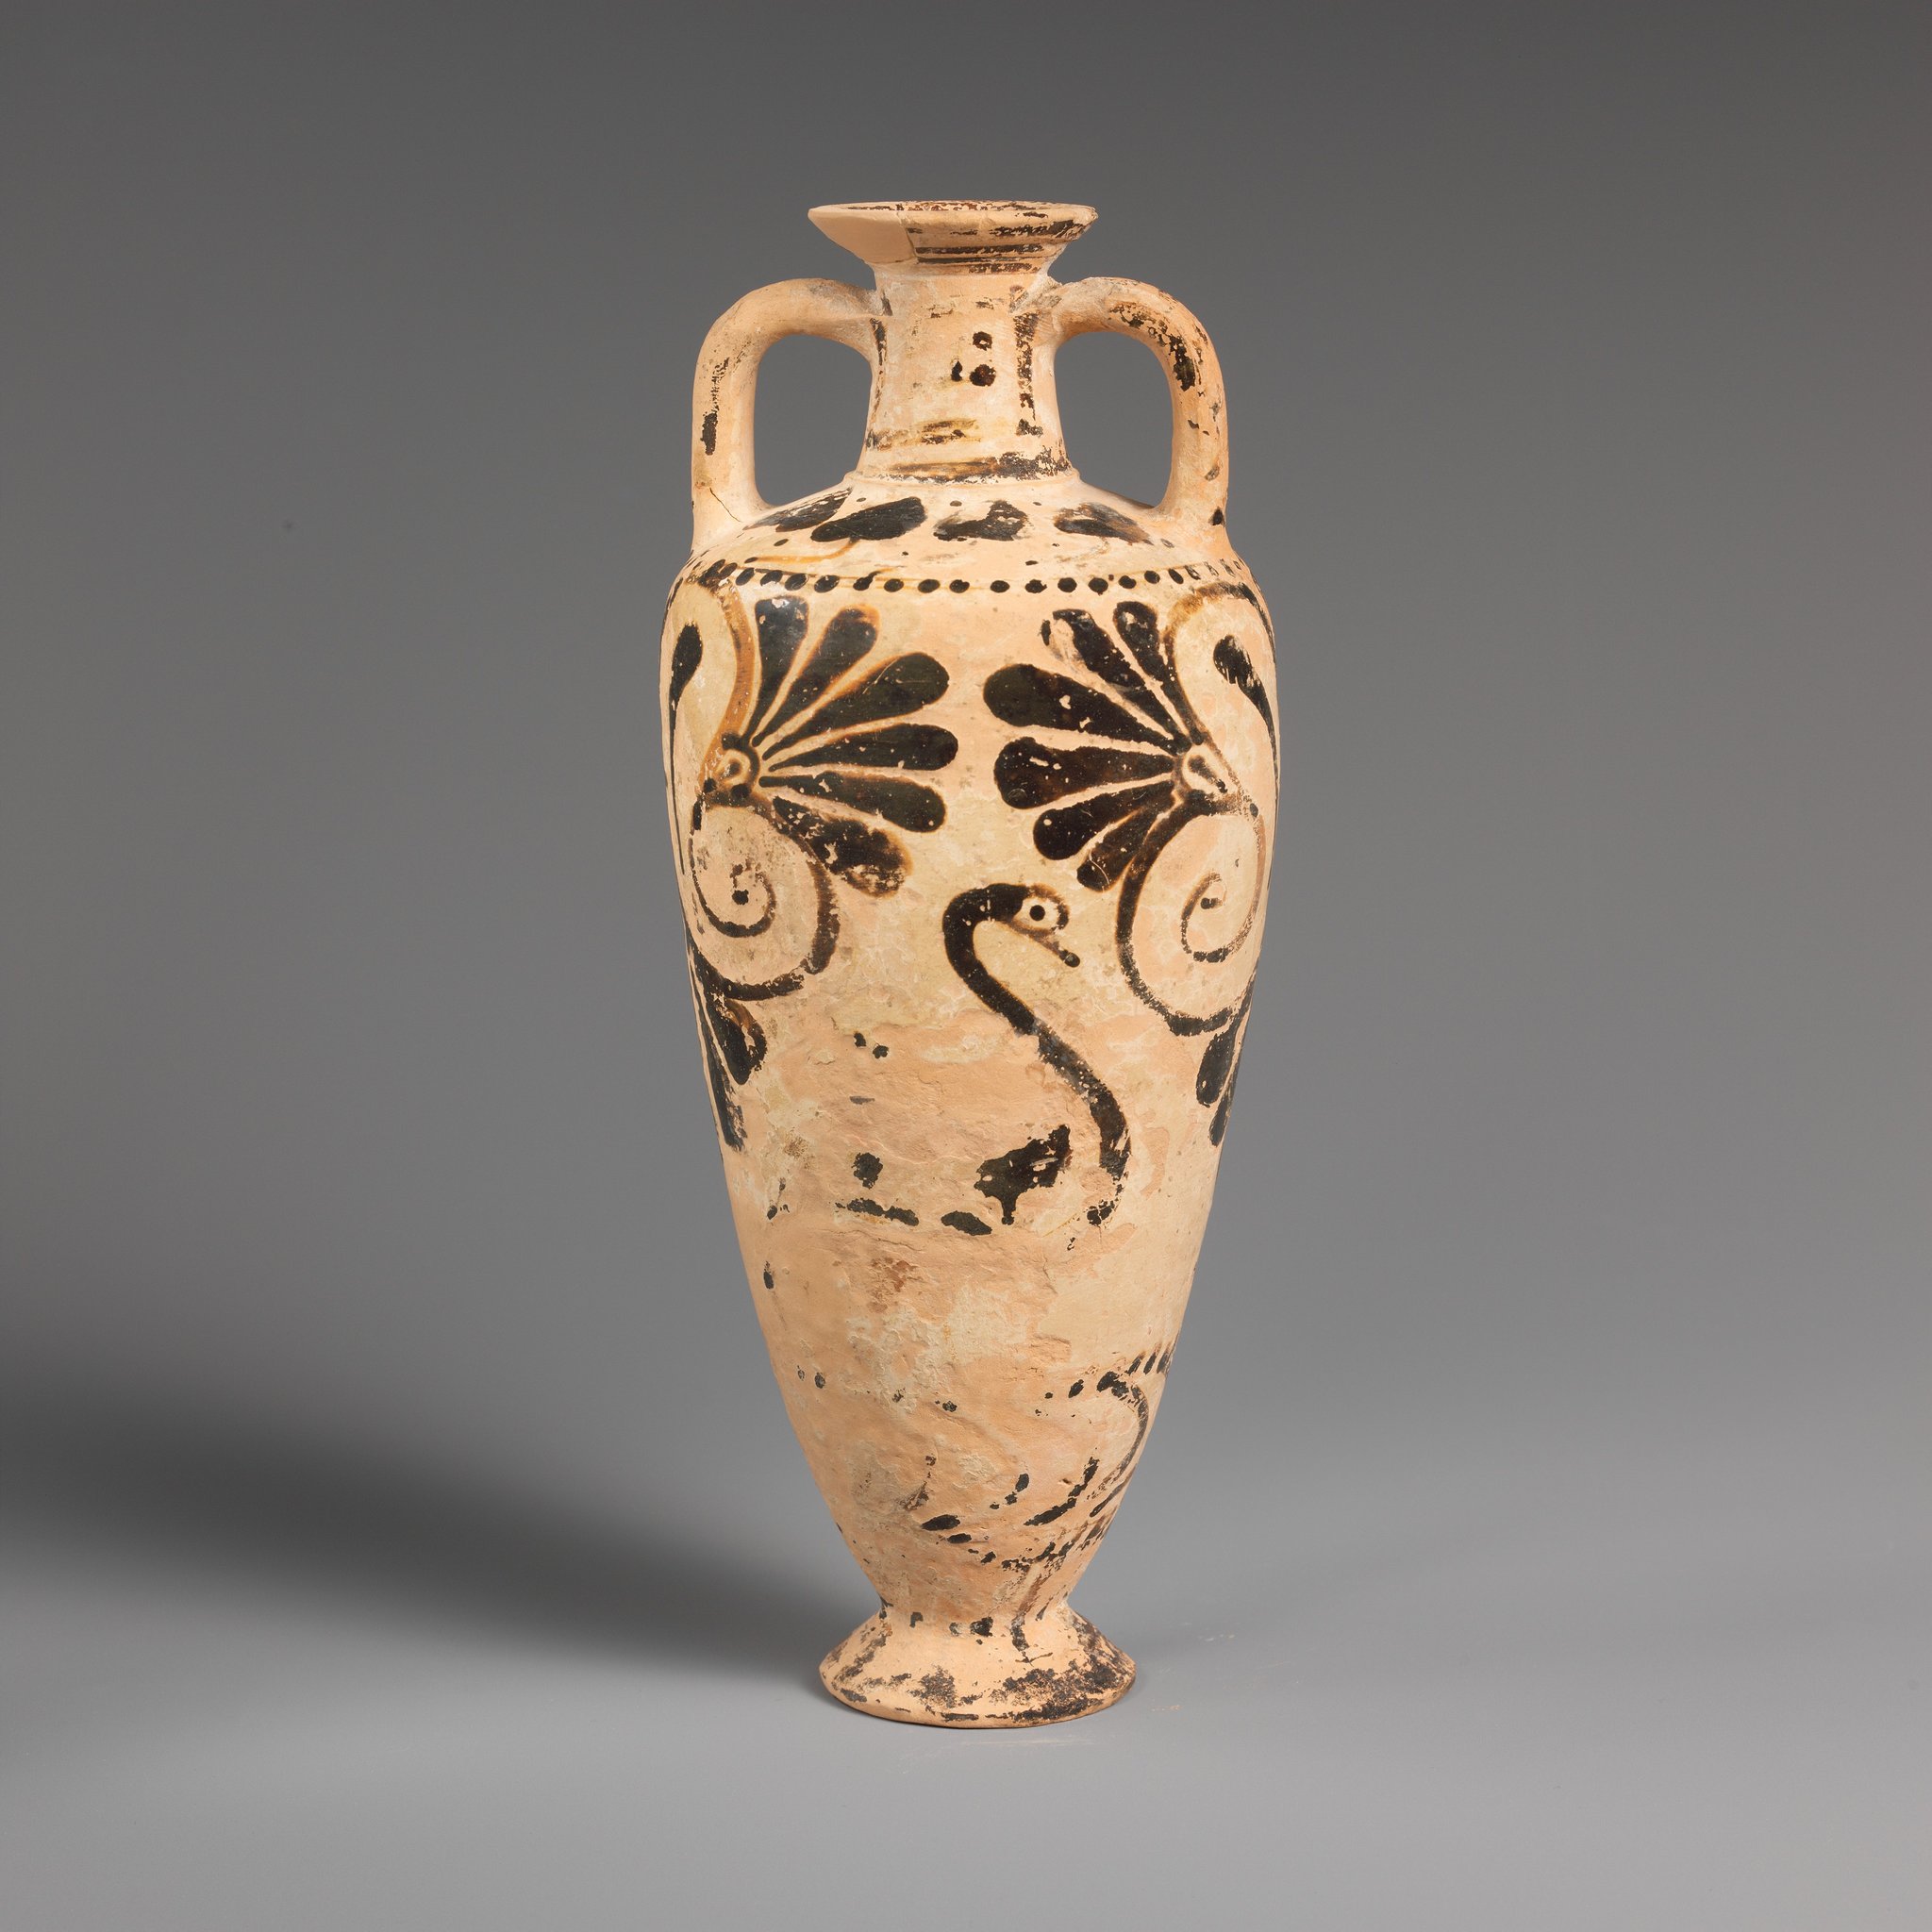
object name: amphoriskos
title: Terracotta amphoriskos (oil flask)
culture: greek, east, milesian, fikellura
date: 550-525 BCE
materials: terracotta